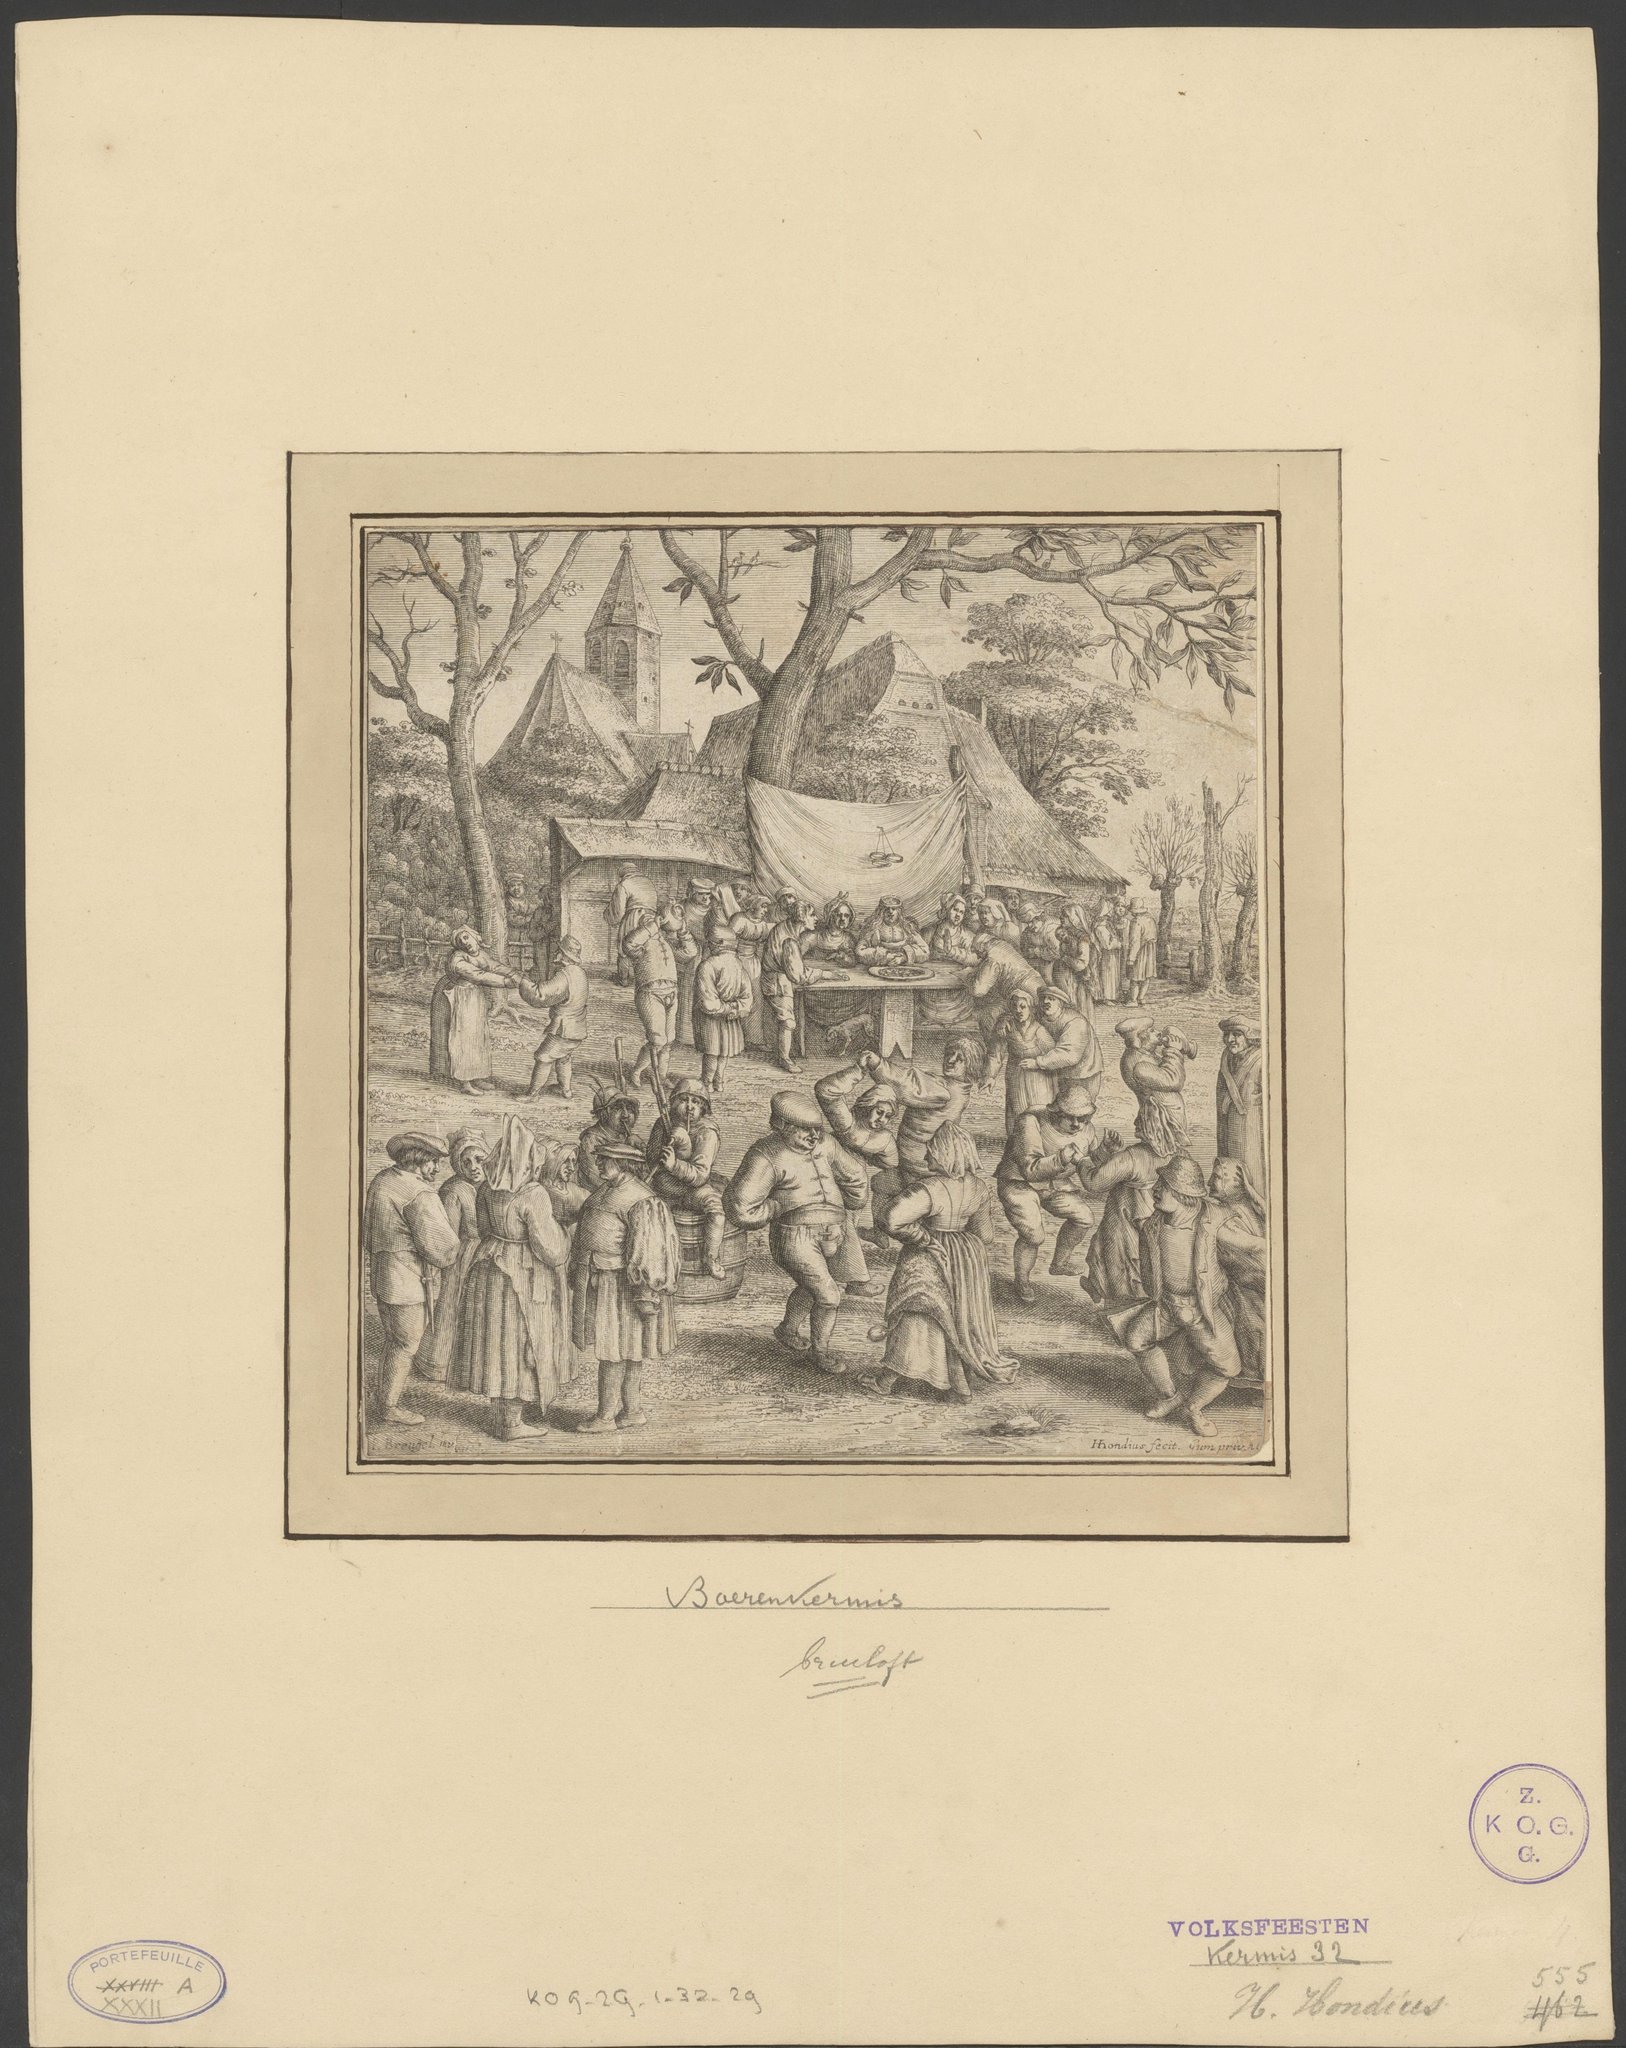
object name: print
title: Boerenbruiloft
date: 1644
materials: paper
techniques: engraving, etching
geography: netherlands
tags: one person playing wind instrument, bagpipe, musette, dancing at wedding feast, farmers, folk dancing (men and women together)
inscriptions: collector's mark, collector's mark: Lugt 1641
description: Boerenbruiloft. Aan een tafel in de open lucht zit een boerenbruid, onder een krans. Op de voorgrond dansende boeren en boerinnen en twee doedelzakspelers bij een ton. Op de achtergrond een kerk. Met een apart fragment met het onderschrift en adres toegevoegd, onder de prent. Onderwerpsrubrieken binnen de Atlas Zeden en Gewoonten: Volksfeesten; Kermis.